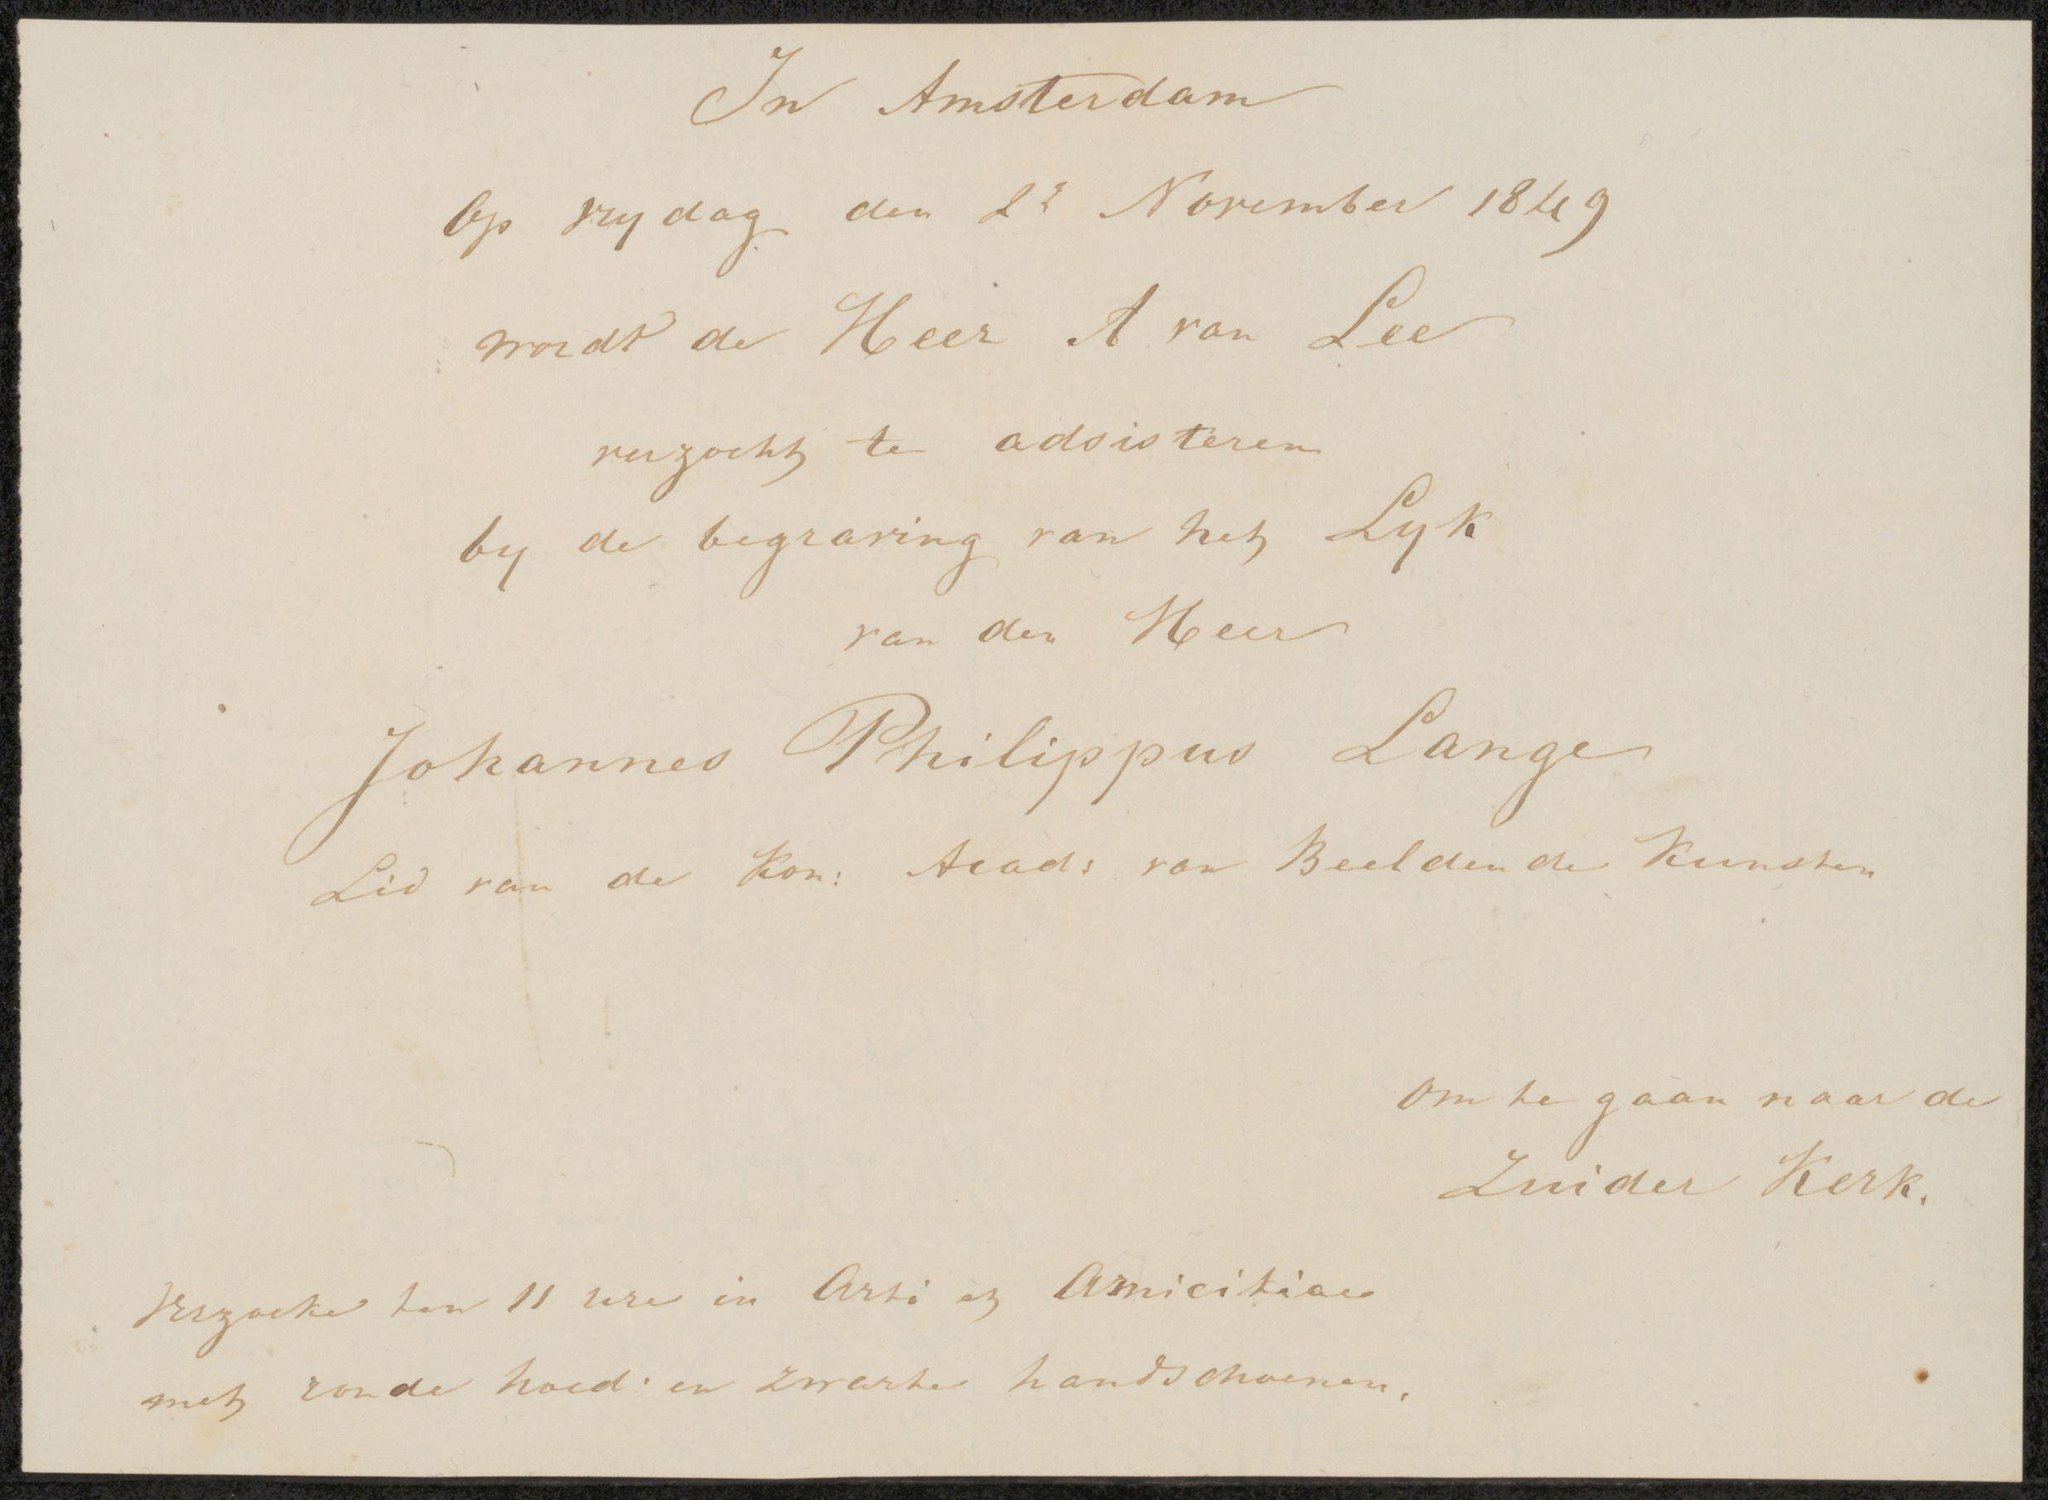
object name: letter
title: Brief aan Abraham van Lee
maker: Anonymous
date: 1849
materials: ink, paper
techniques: pen, writing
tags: painter, print maker, abraham van lee, amsterdam, johannes philippus lange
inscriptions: watermark